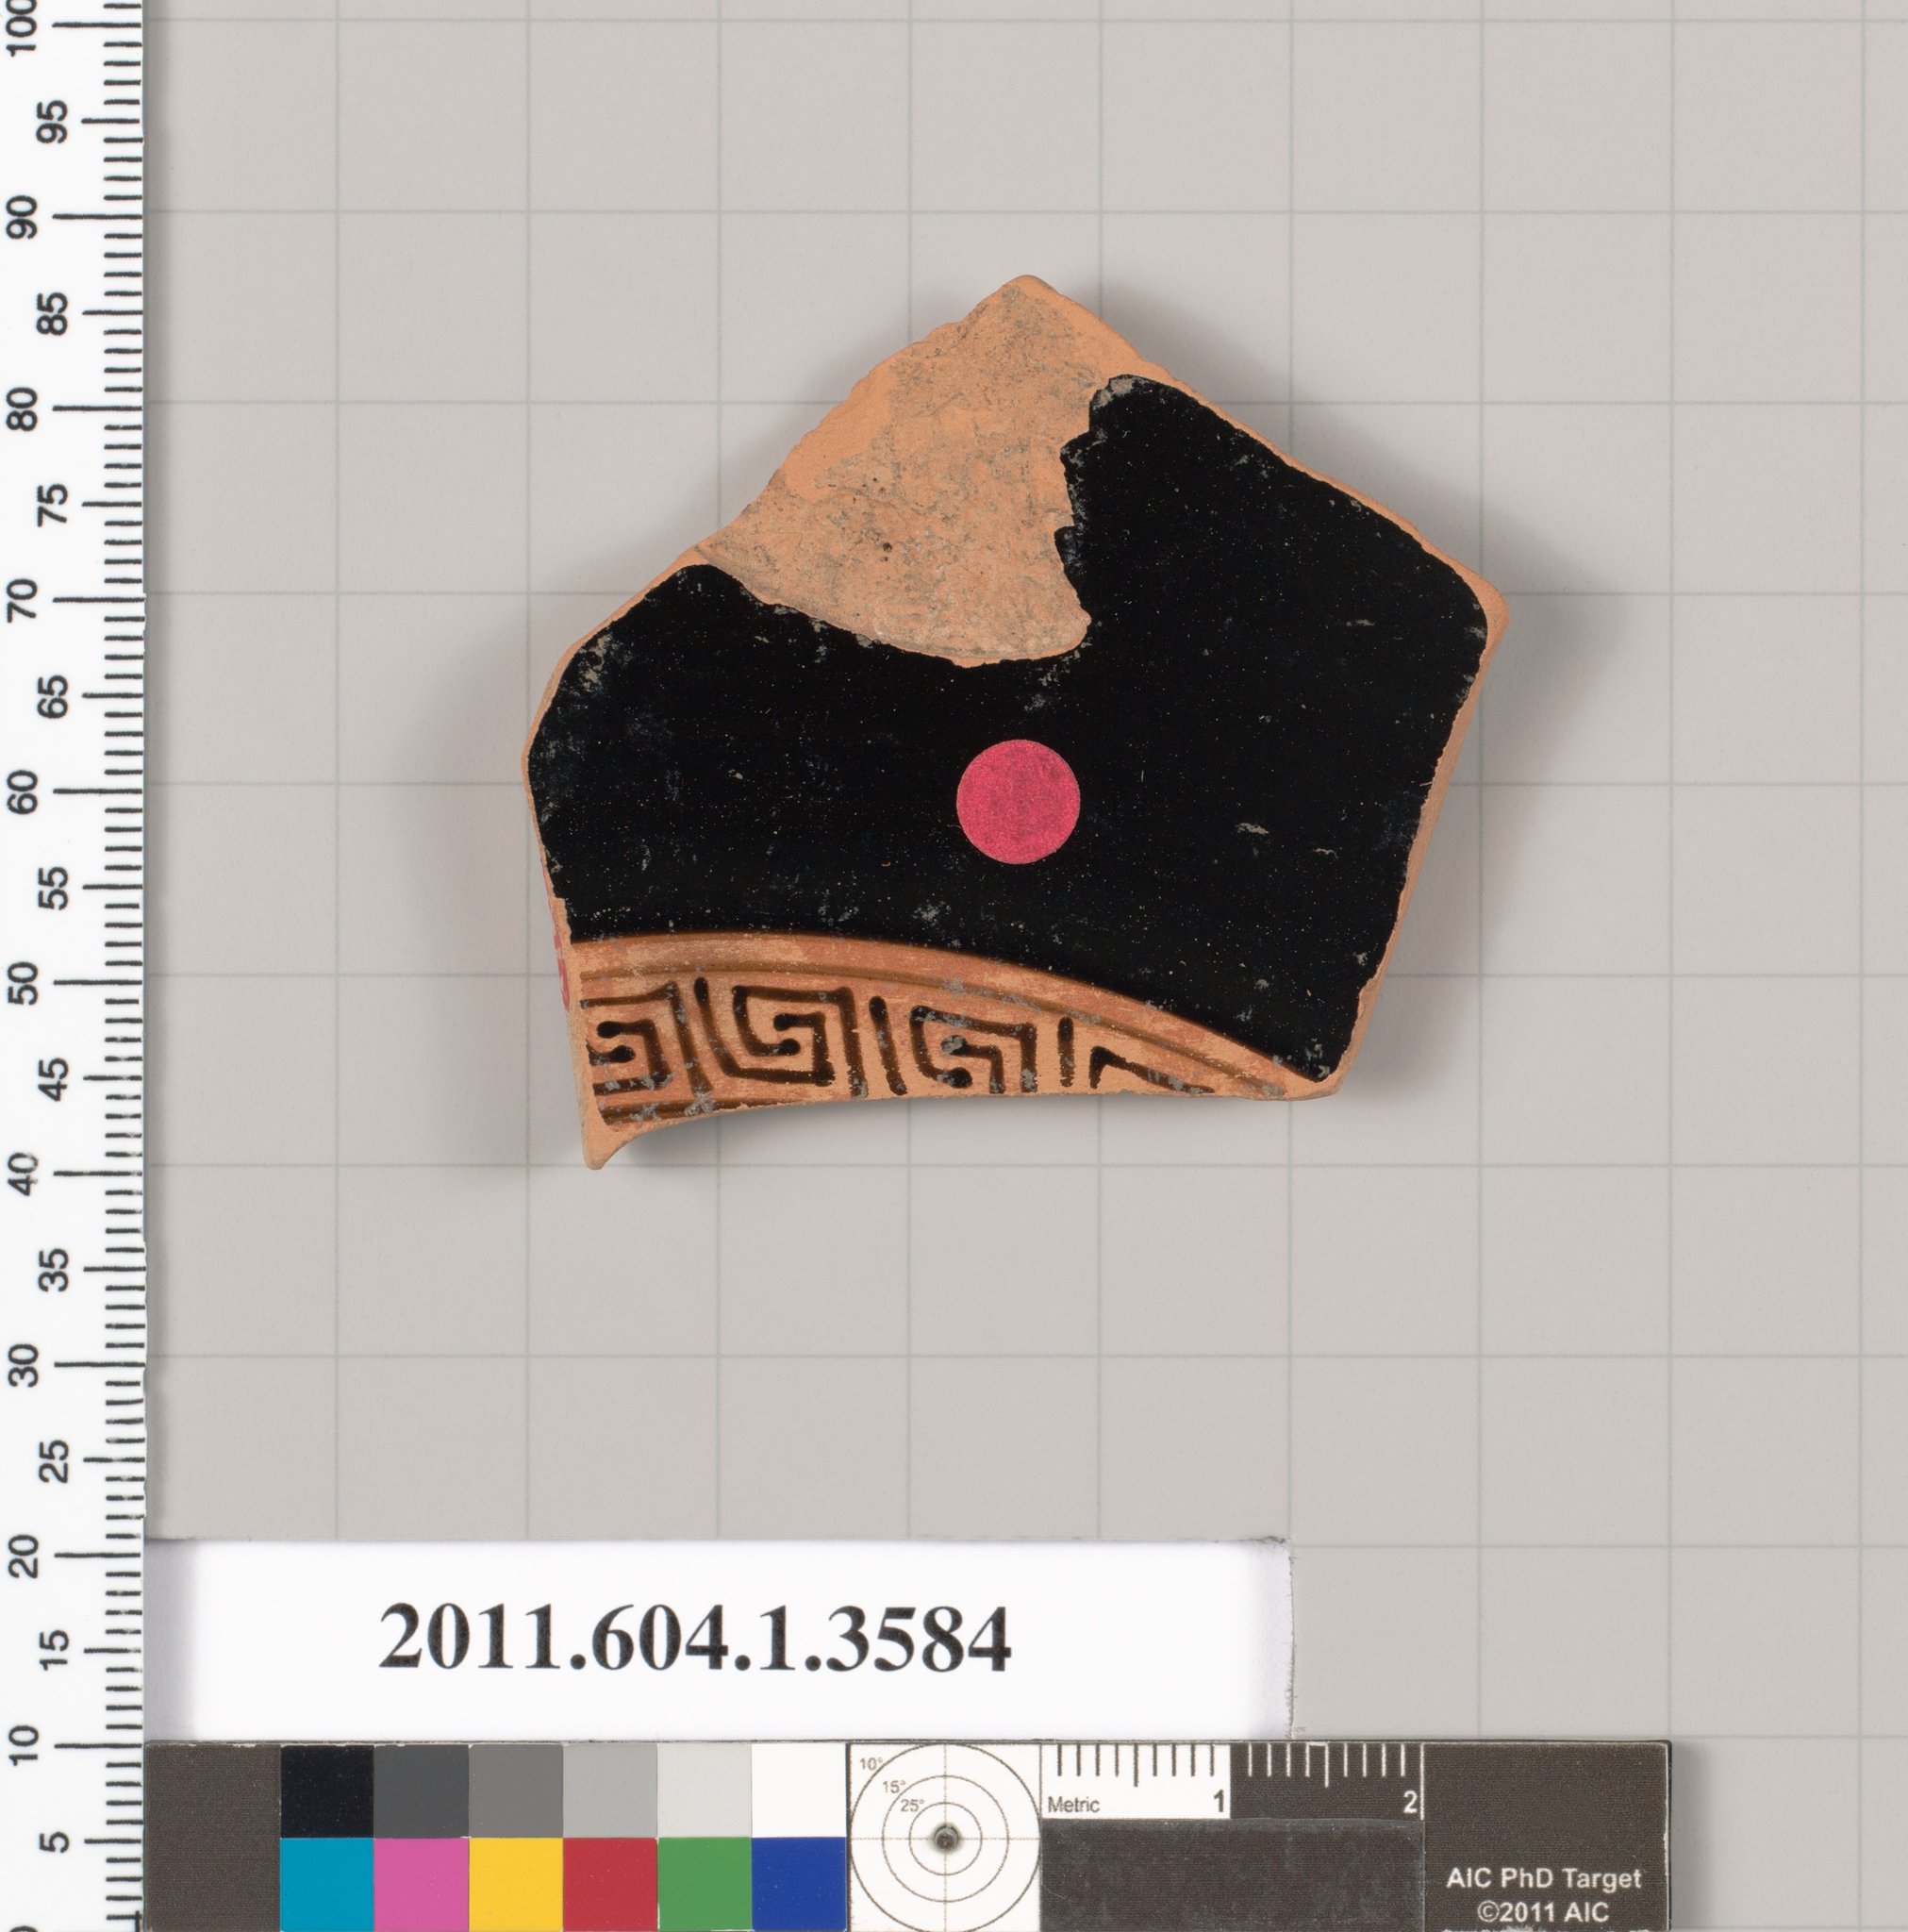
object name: kylix fragment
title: Terracotta fragment of a kylix (drinking cup)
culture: greek, attic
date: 475-451 BCE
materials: terracotta